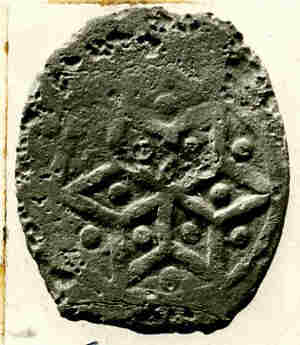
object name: coin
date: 1067-1233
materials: copper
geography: iran